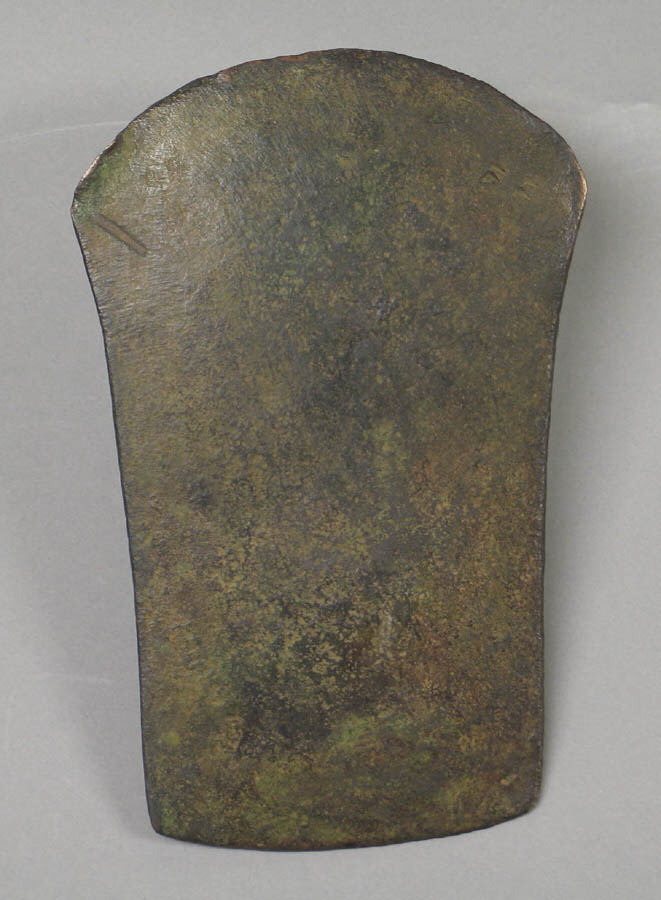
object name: ax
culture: indian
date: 1500-500 BCE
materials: copper